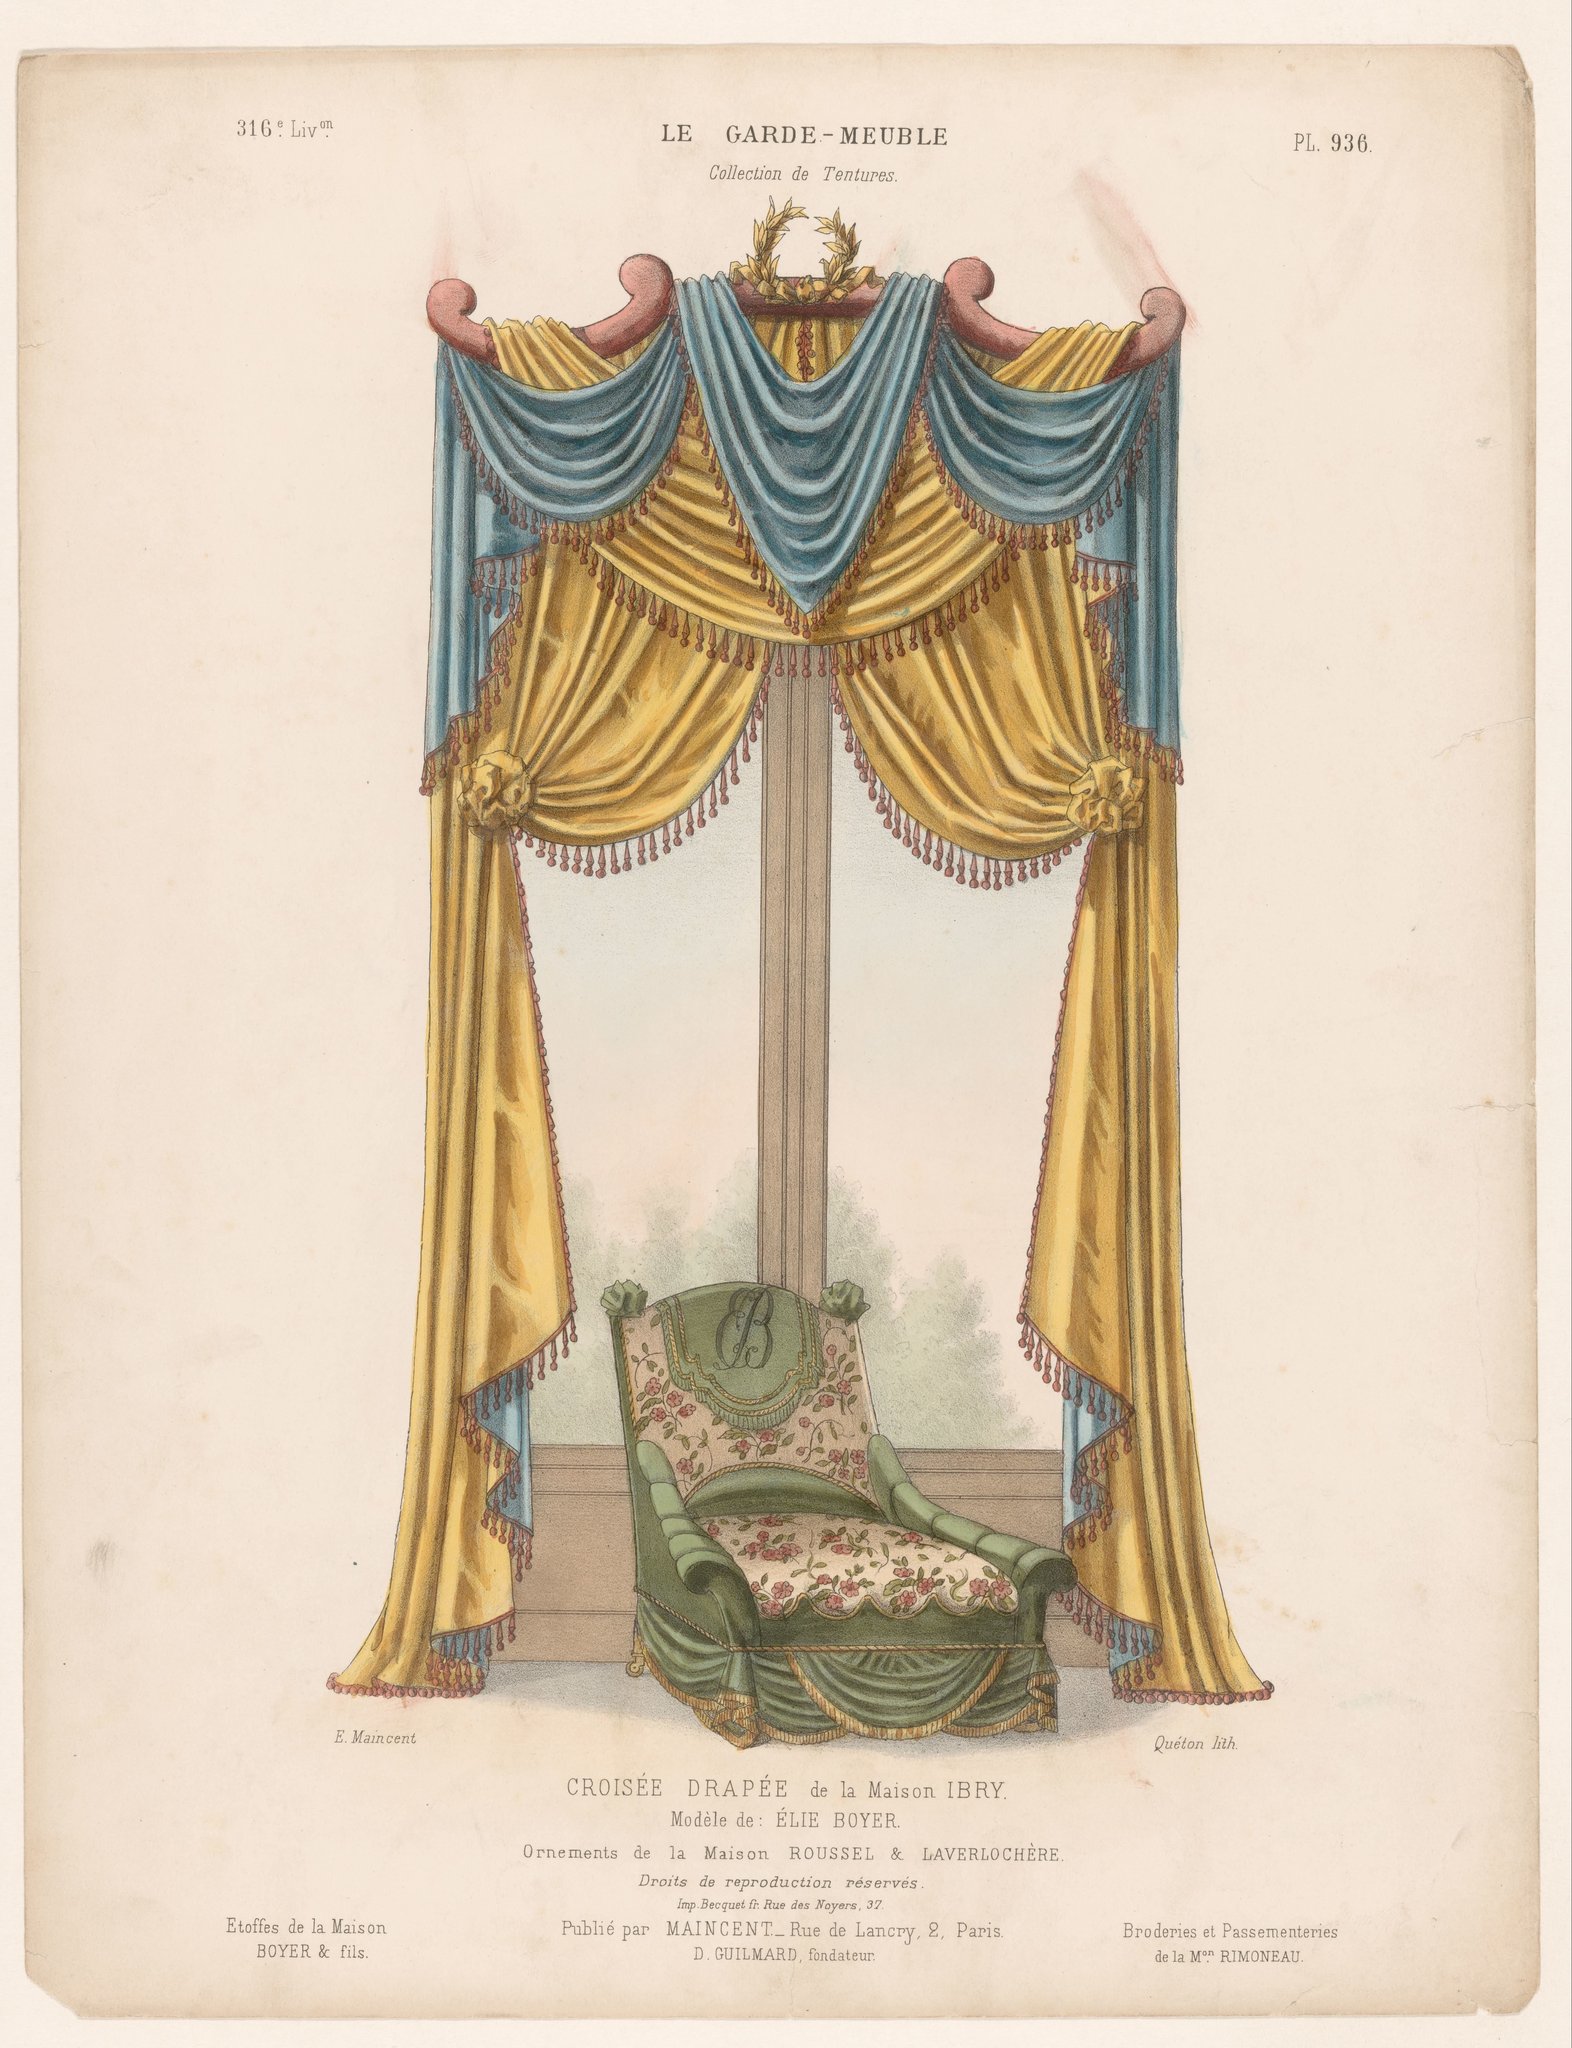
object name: print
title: Le Garde-Meuble / Collection de Tentures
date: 1885-1895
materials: paper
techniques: hand coloring, lithograph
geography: paris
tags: armchair, seat, window, hangings and drapery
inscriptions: : ‘Droits de reproduction réservés.’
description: Kruisvenster met fauteuil en gedrapeerde gordijnen van Maison Ibry, naar ontwerp van Elie Boyer. Prent uit 316e Livraison.